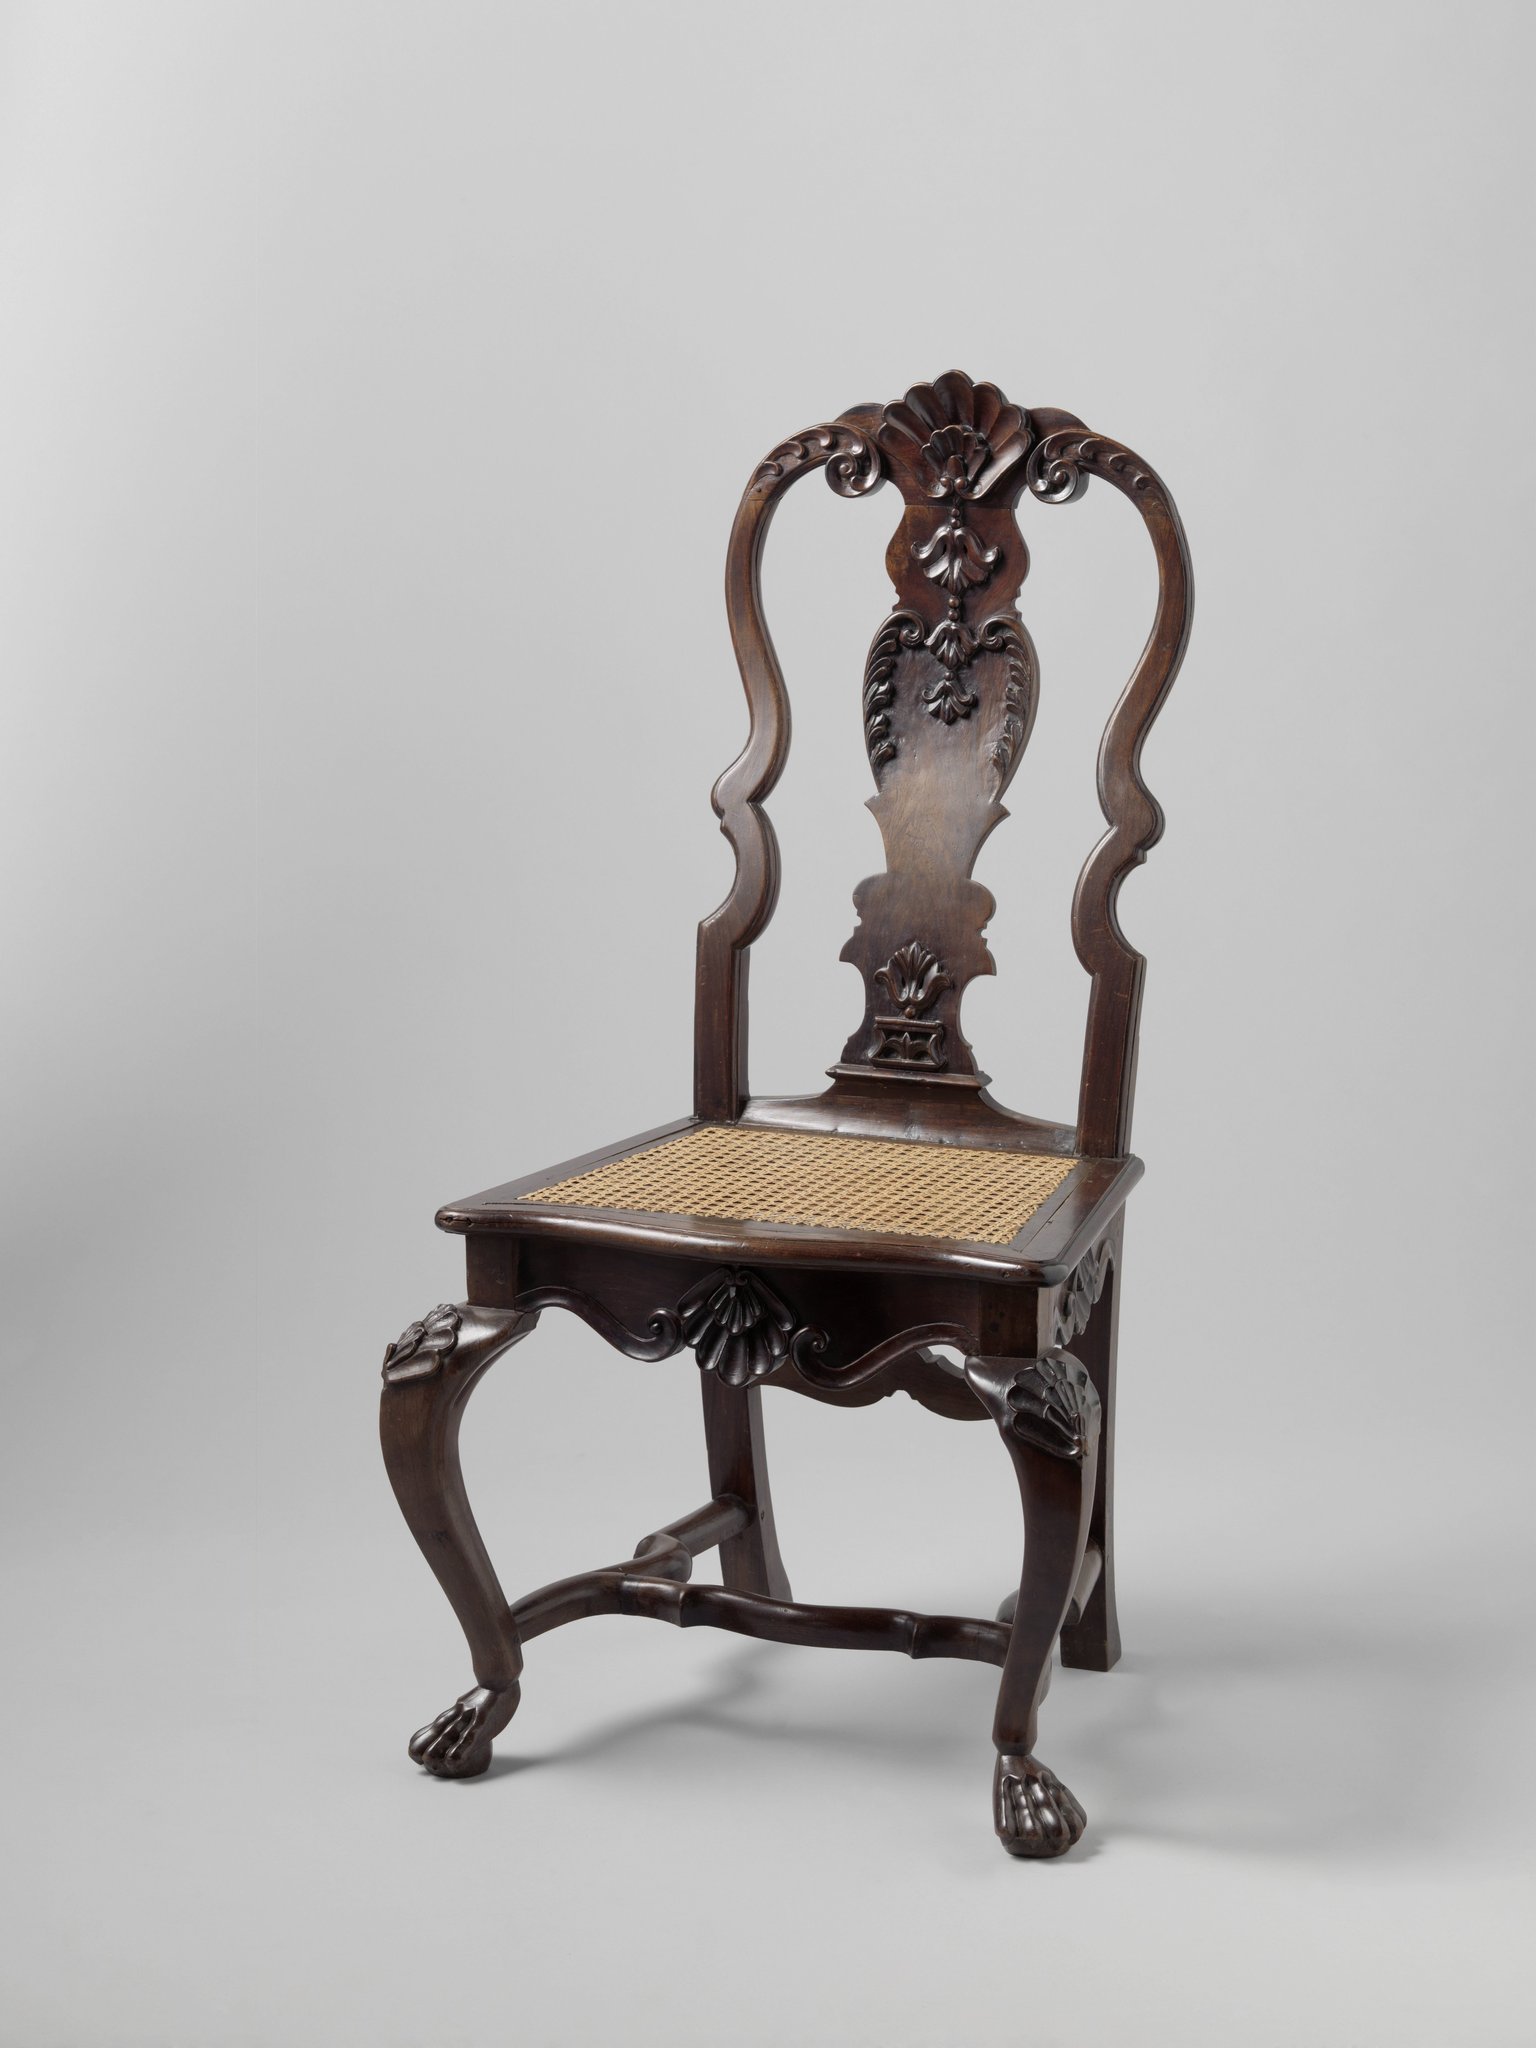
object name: chair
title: Stoel van ijzerhout en met rotan bespannen zitting (serie van 4 stoelen)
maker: Anonymous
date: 1725-1750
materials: wood, rattan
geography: japan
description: Four chairs. Ironwood, cane. Indonesia, c. 1725 - 1750. Purchased from Stichting Cultuurgeschiedenis Nederlanders Overzee.